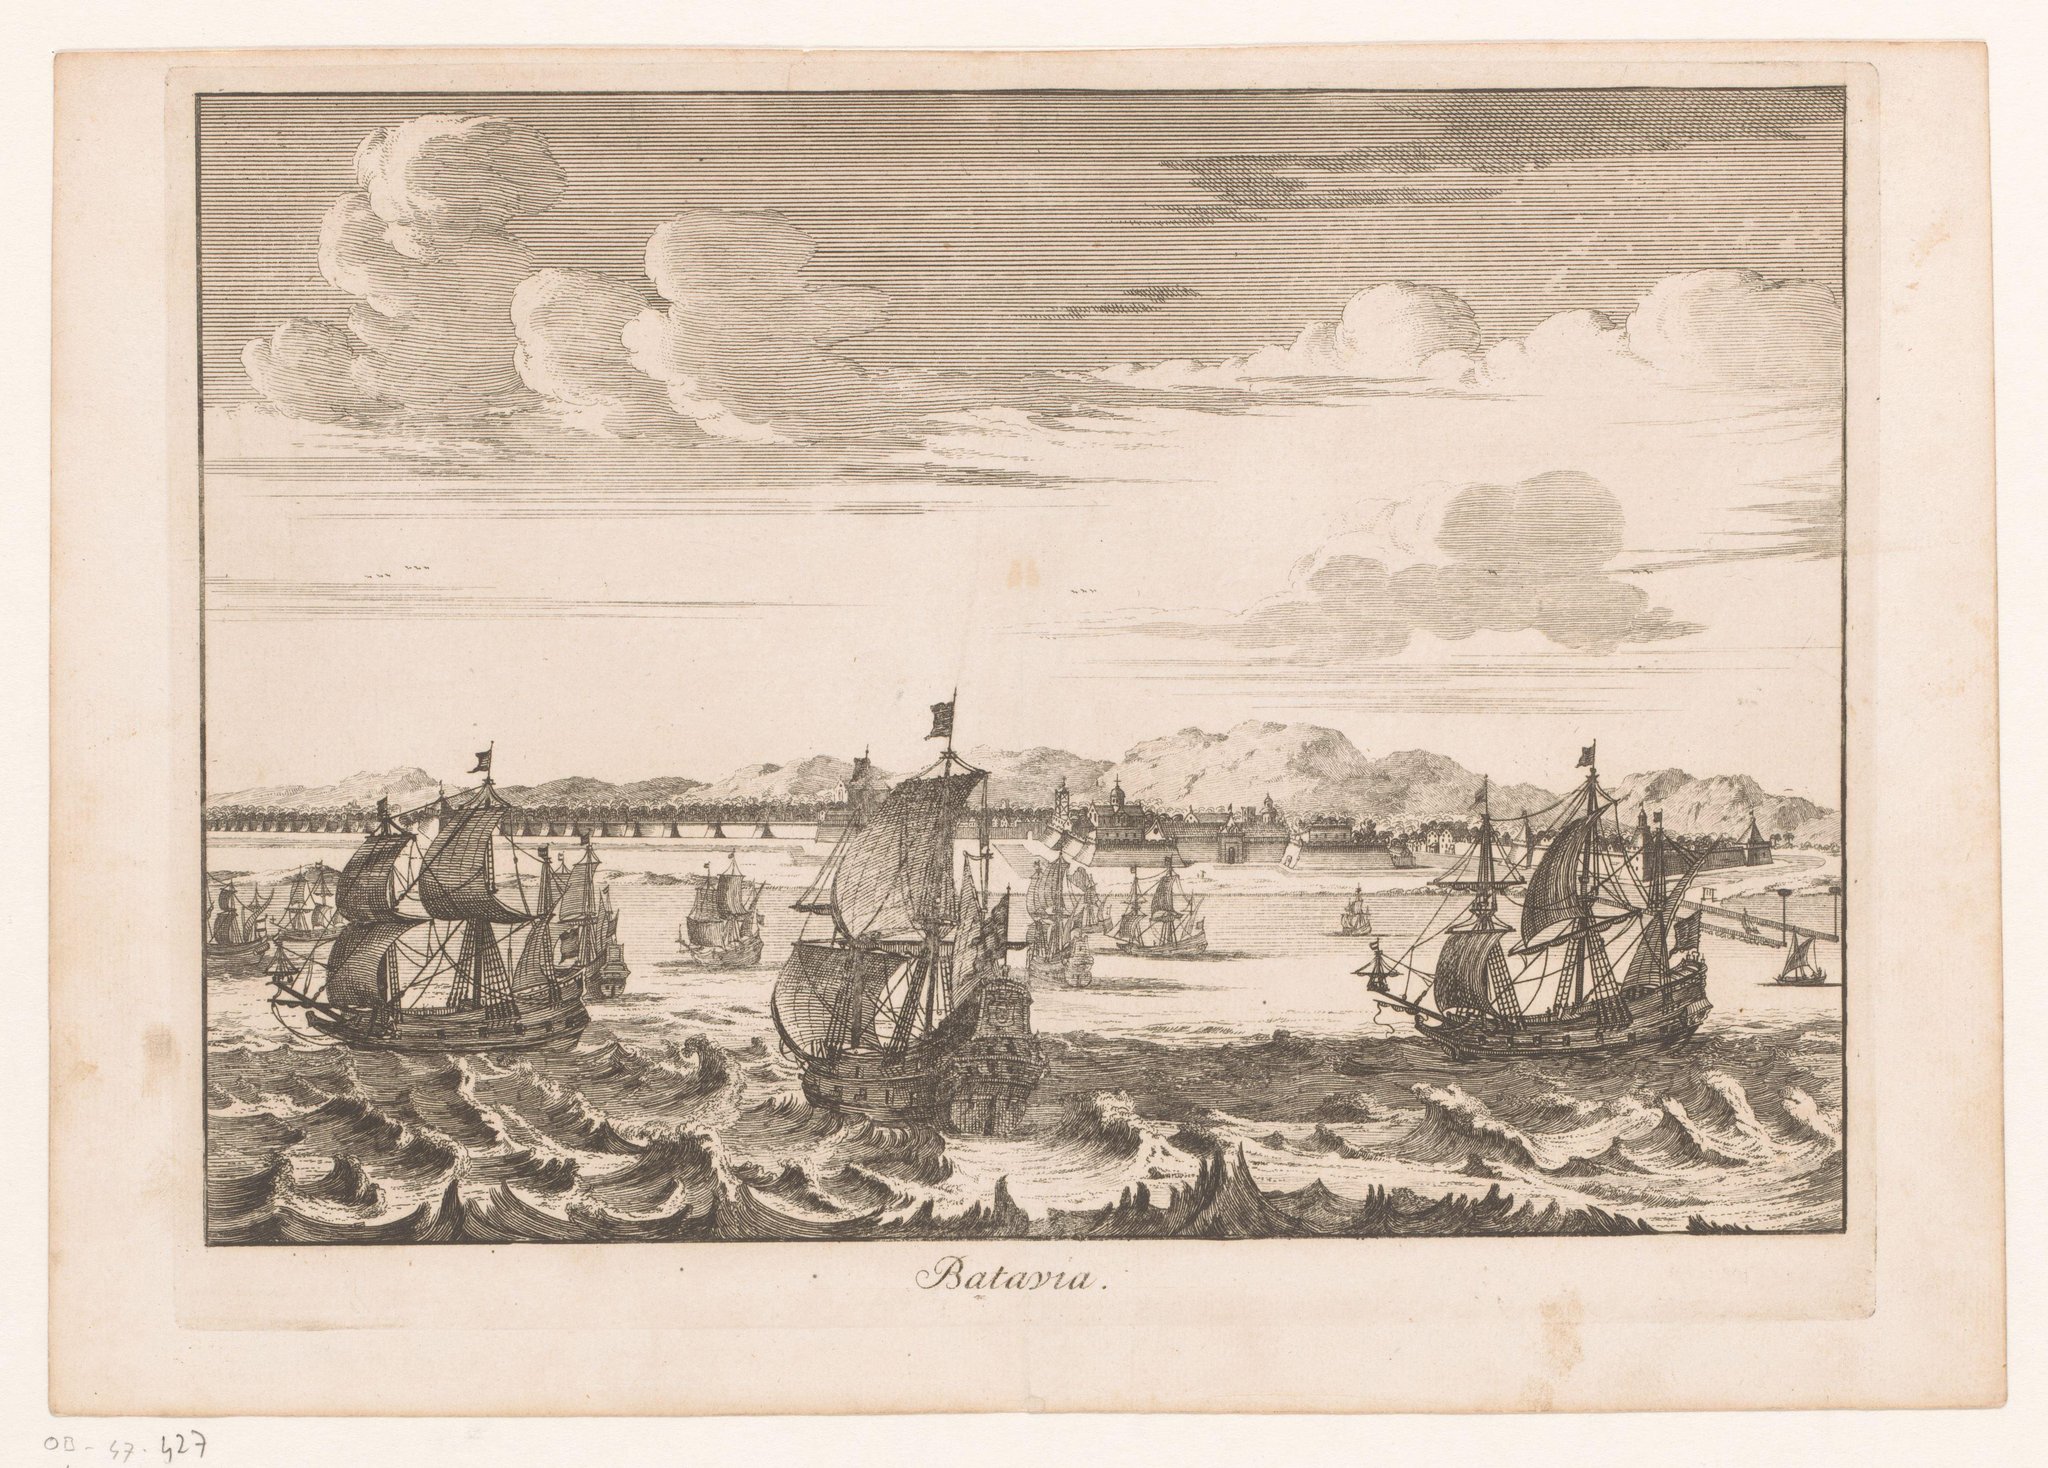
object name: print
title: Batavia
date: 1705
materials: paper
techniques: engraving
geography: amsterdam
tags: island (in tropical and sub-tropical regions), ship in the roads, roadstead, batavia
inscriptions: collector's mark: Lugt 2228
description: Prent uit: Croix, A.P. de la. Algemeene weereld-beschryving, Nae de rechte verdeeling der Landschappen, Plaetsen, Zeeën, Rivieren, &c. (...). 3 dln. Amsterdam: François Halma, 1705.